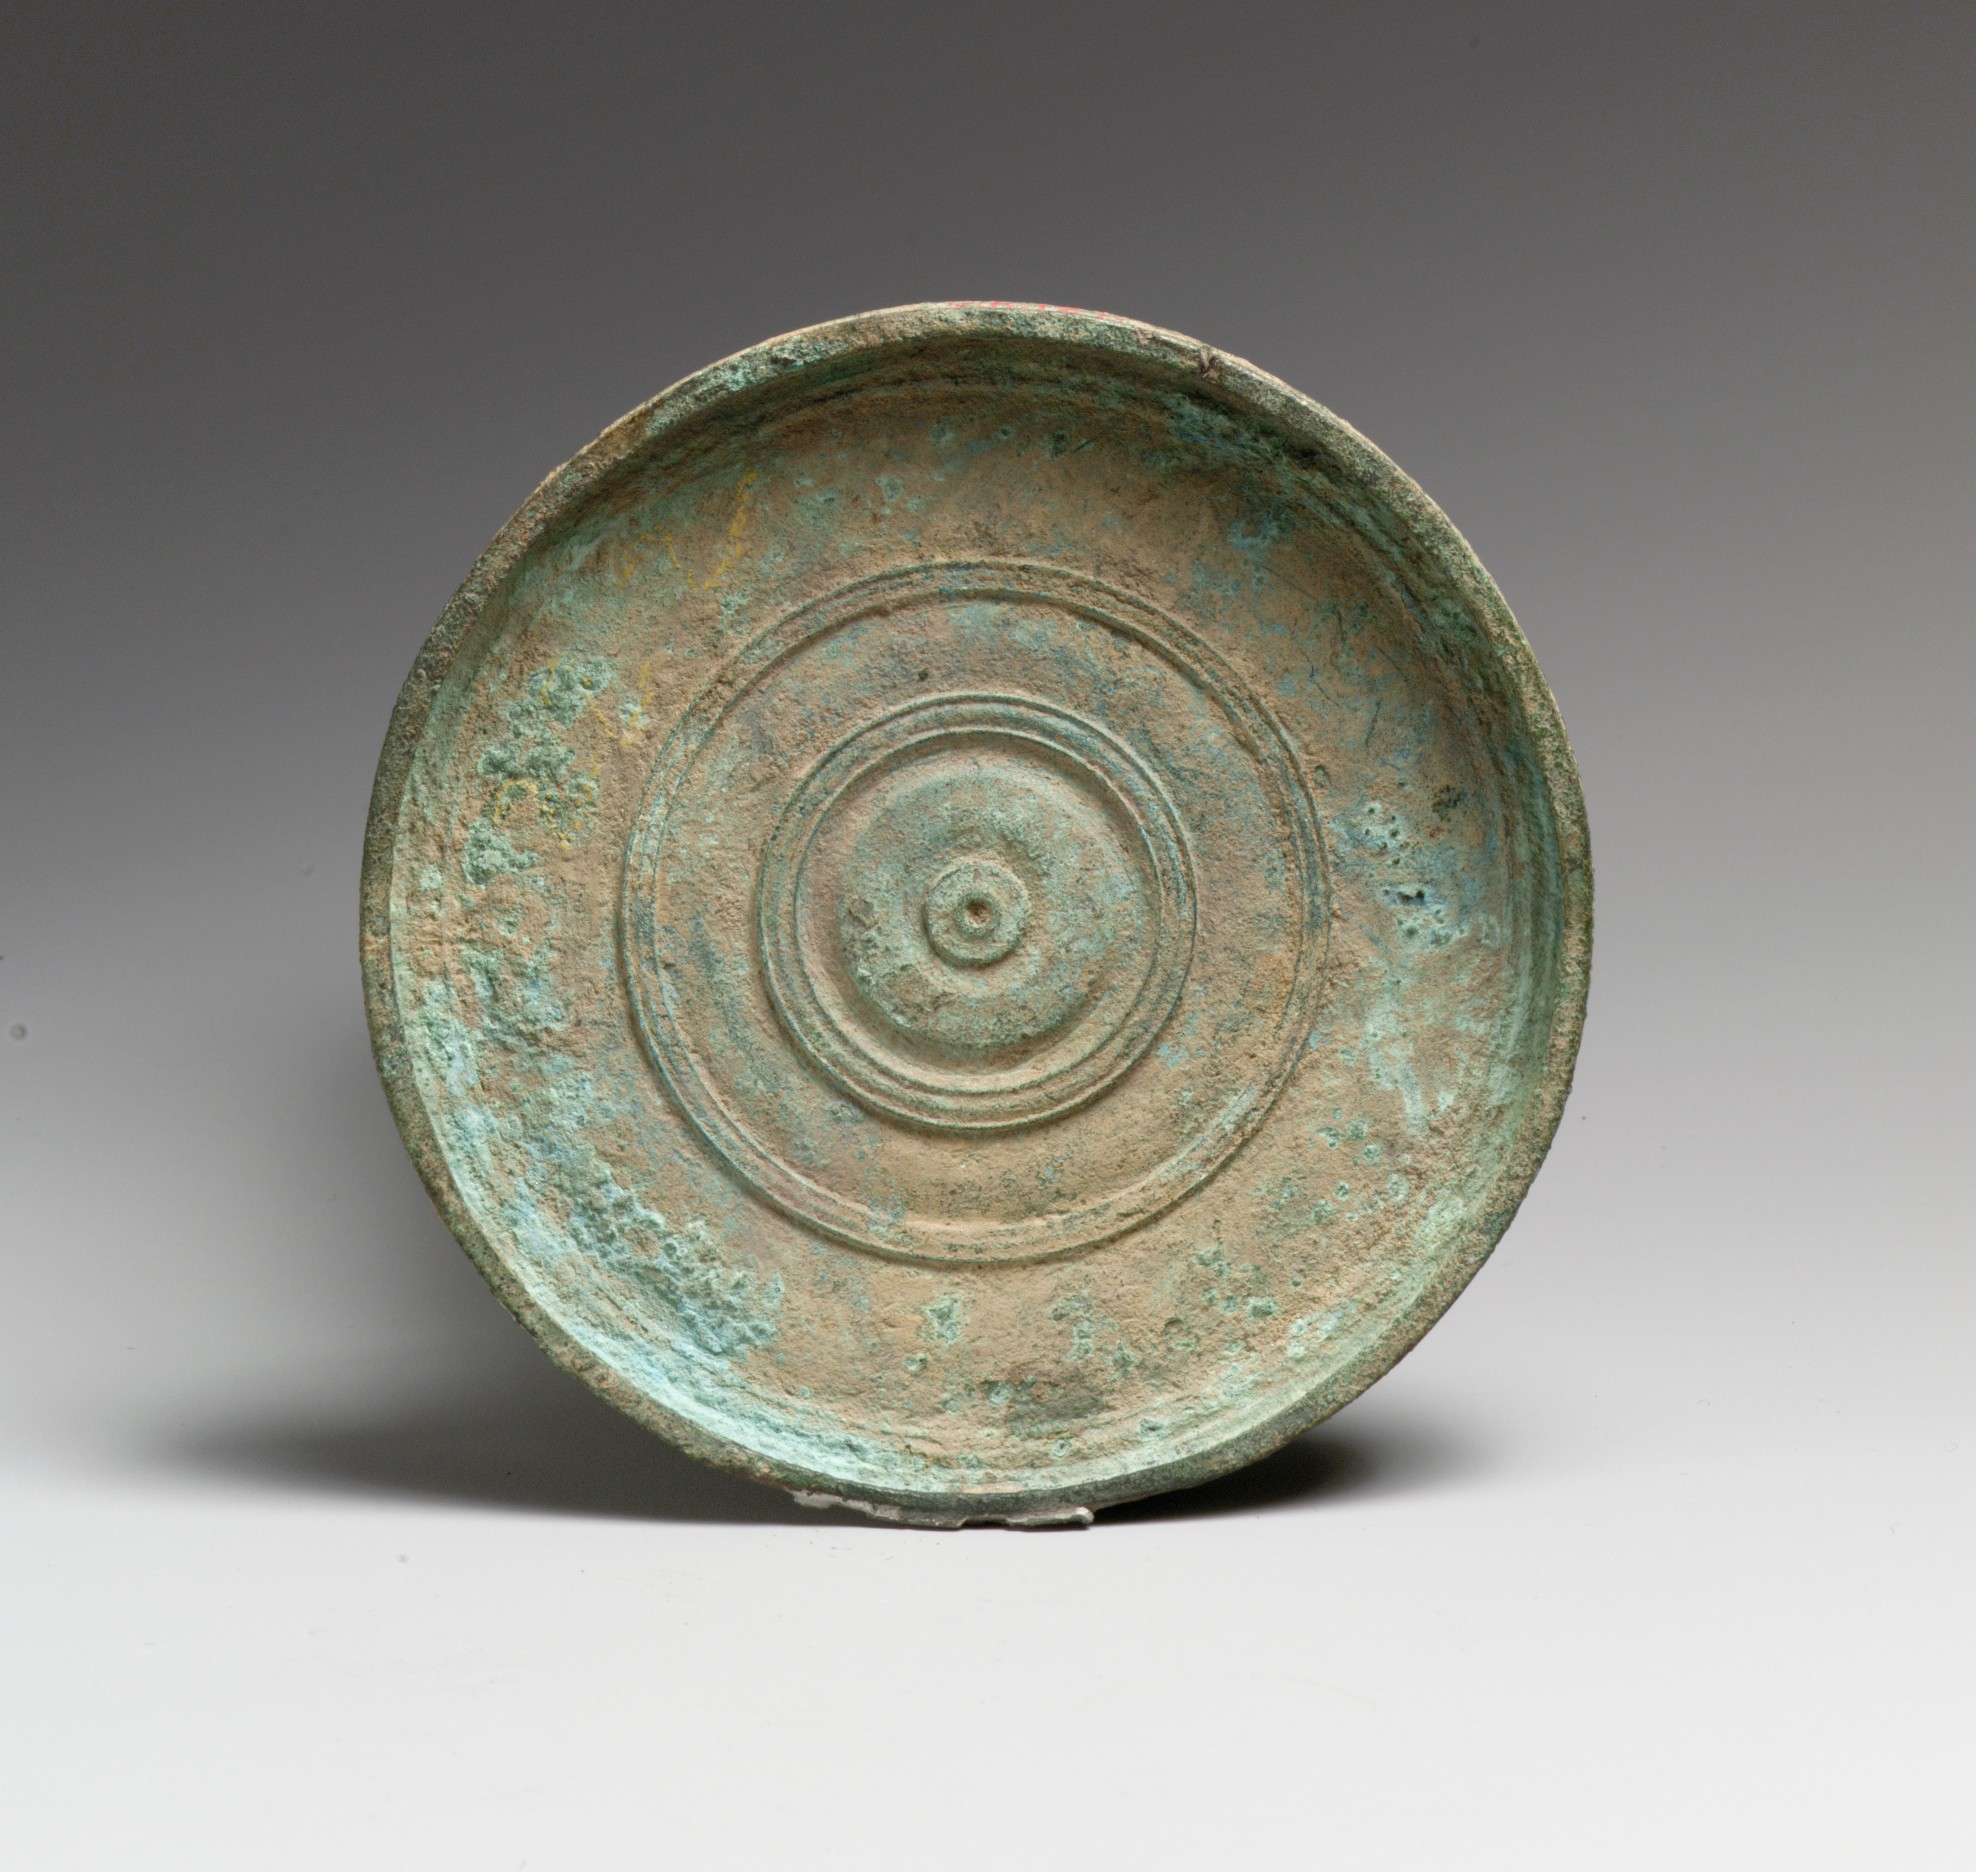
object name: mirror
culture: greek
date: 400-201 BCE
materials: bronze